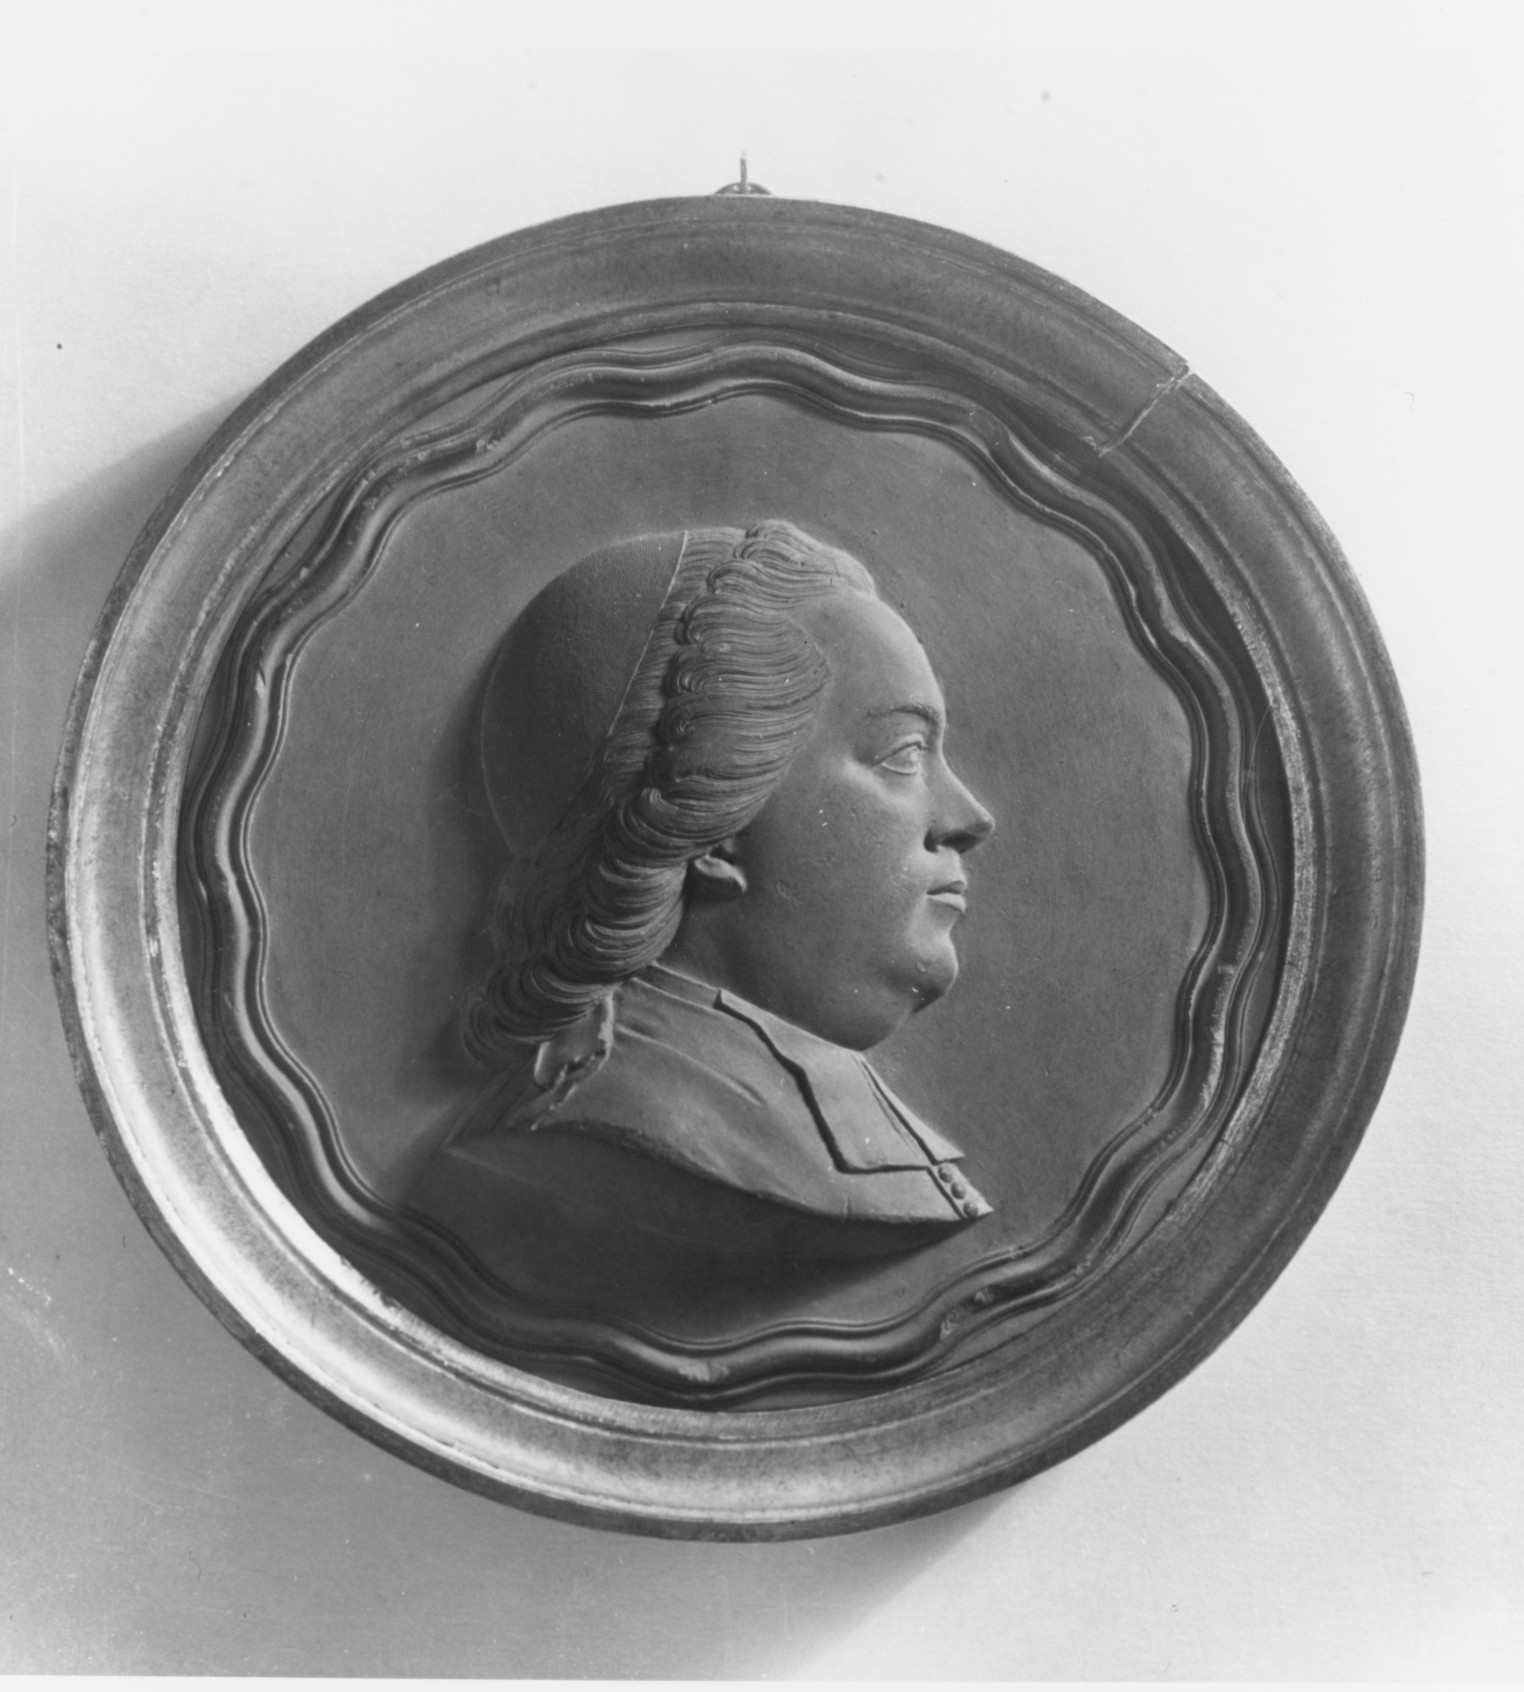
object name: medallion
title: Aimé-Louis des Moulins de L'Isle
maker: jean-baptiste nini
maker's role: artist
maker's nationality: italian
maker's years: 1717-1786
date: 1762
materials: gilt, terracotta, wood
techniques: casting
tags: men,profiles